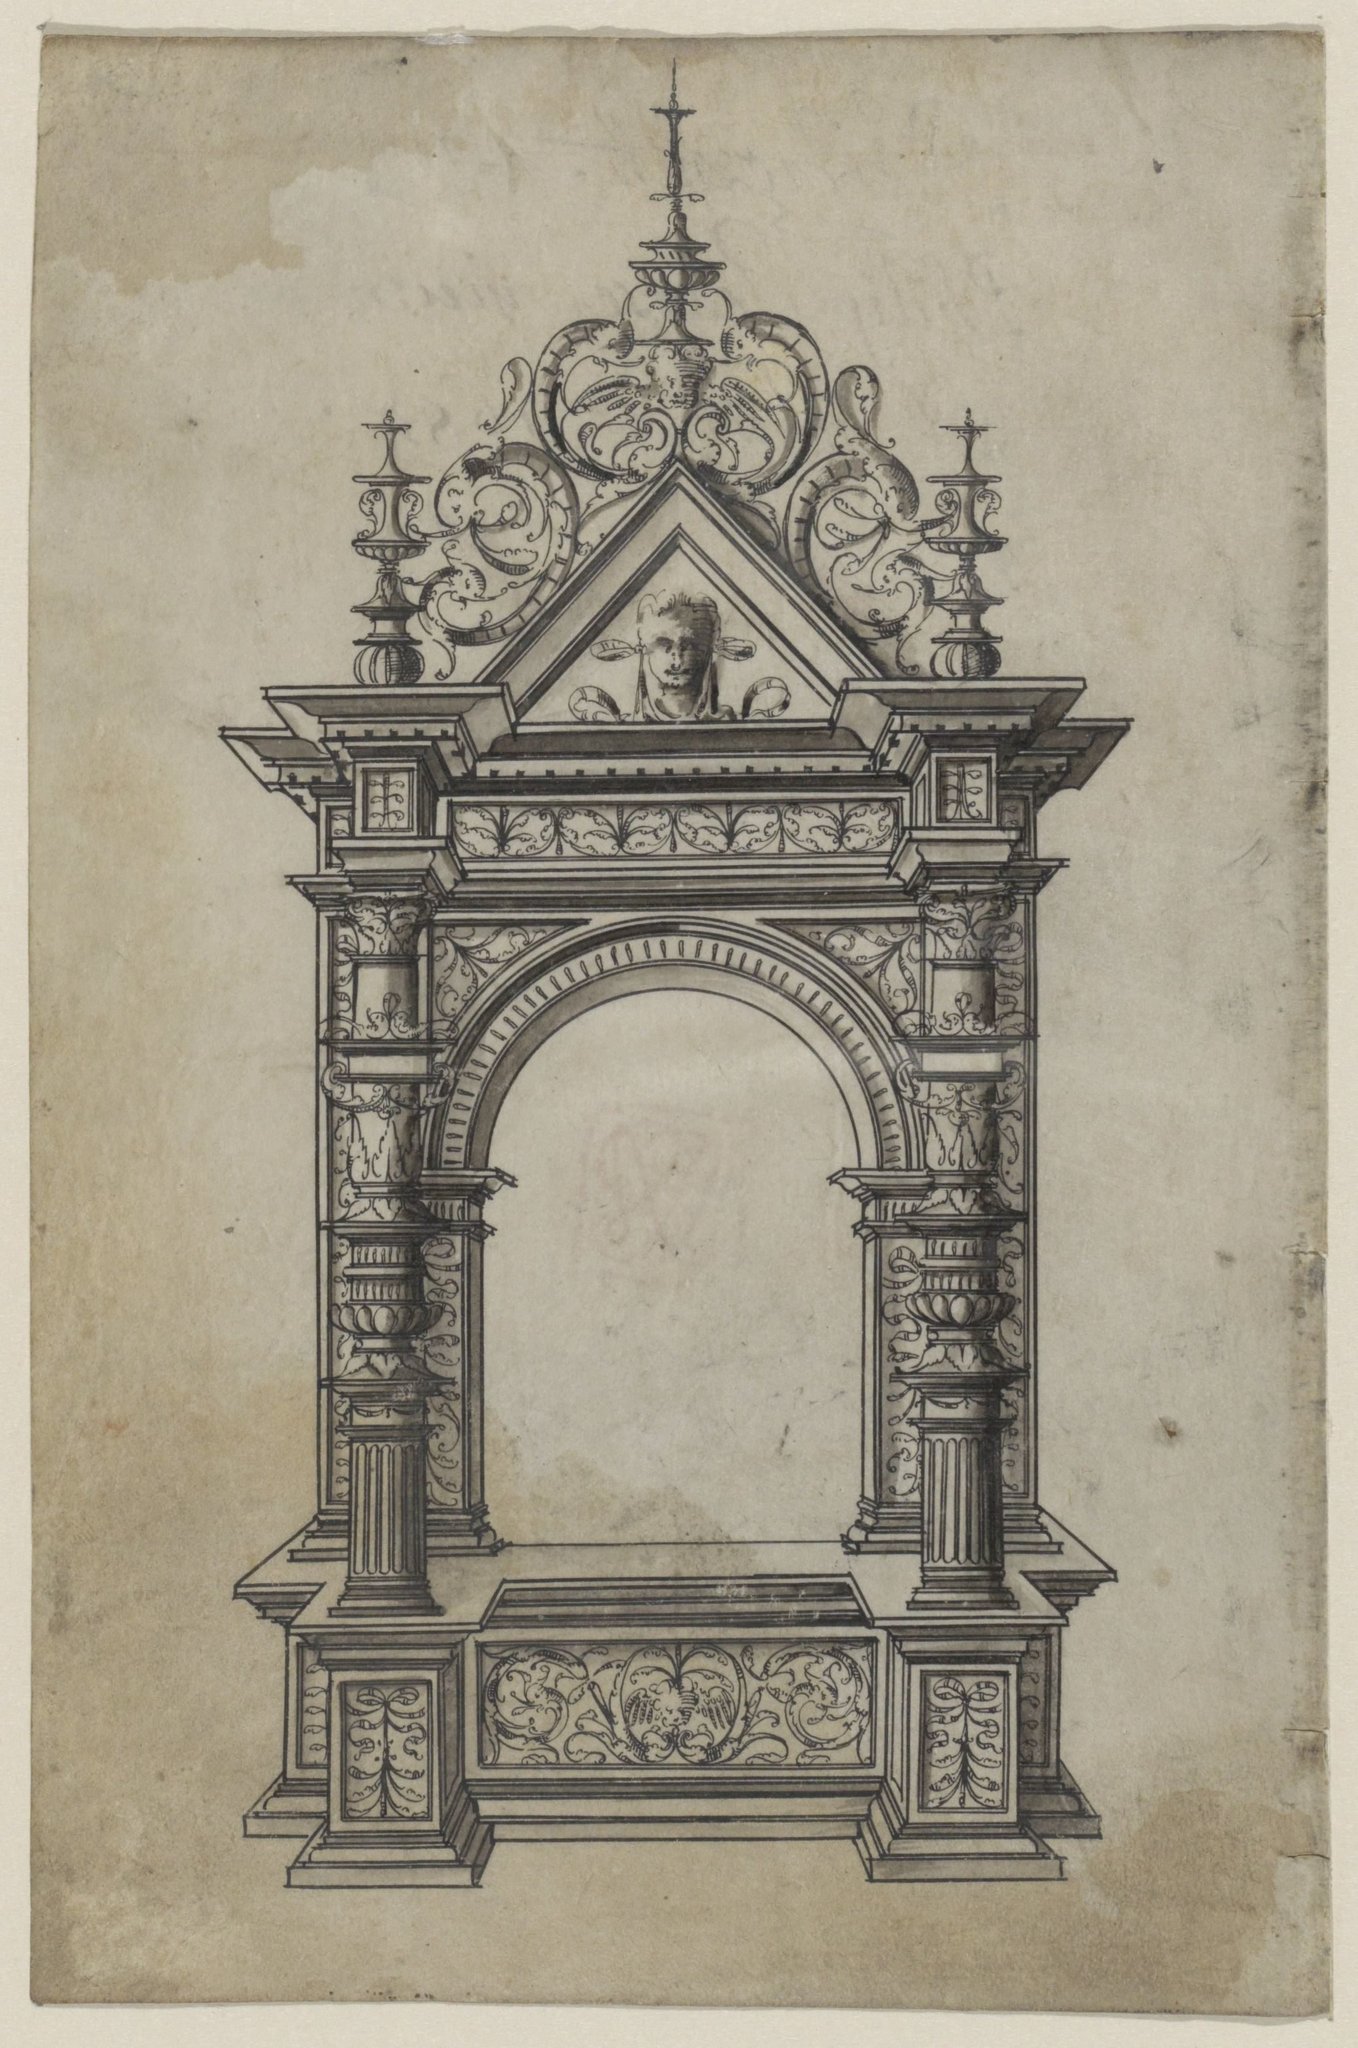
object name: album leaf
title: Altaarretabel of pax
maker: jacques androuet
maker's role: draughtsman, print maker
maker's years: 1515-1584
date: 1543-1553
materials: ink, parchment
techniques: brush, pen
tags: altar with altar-piece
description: Blad 2 verso, los opgezet blad uit een album bestaande uit een band met twee bladen, een schutblad en zeventien apart opgezette bladen.